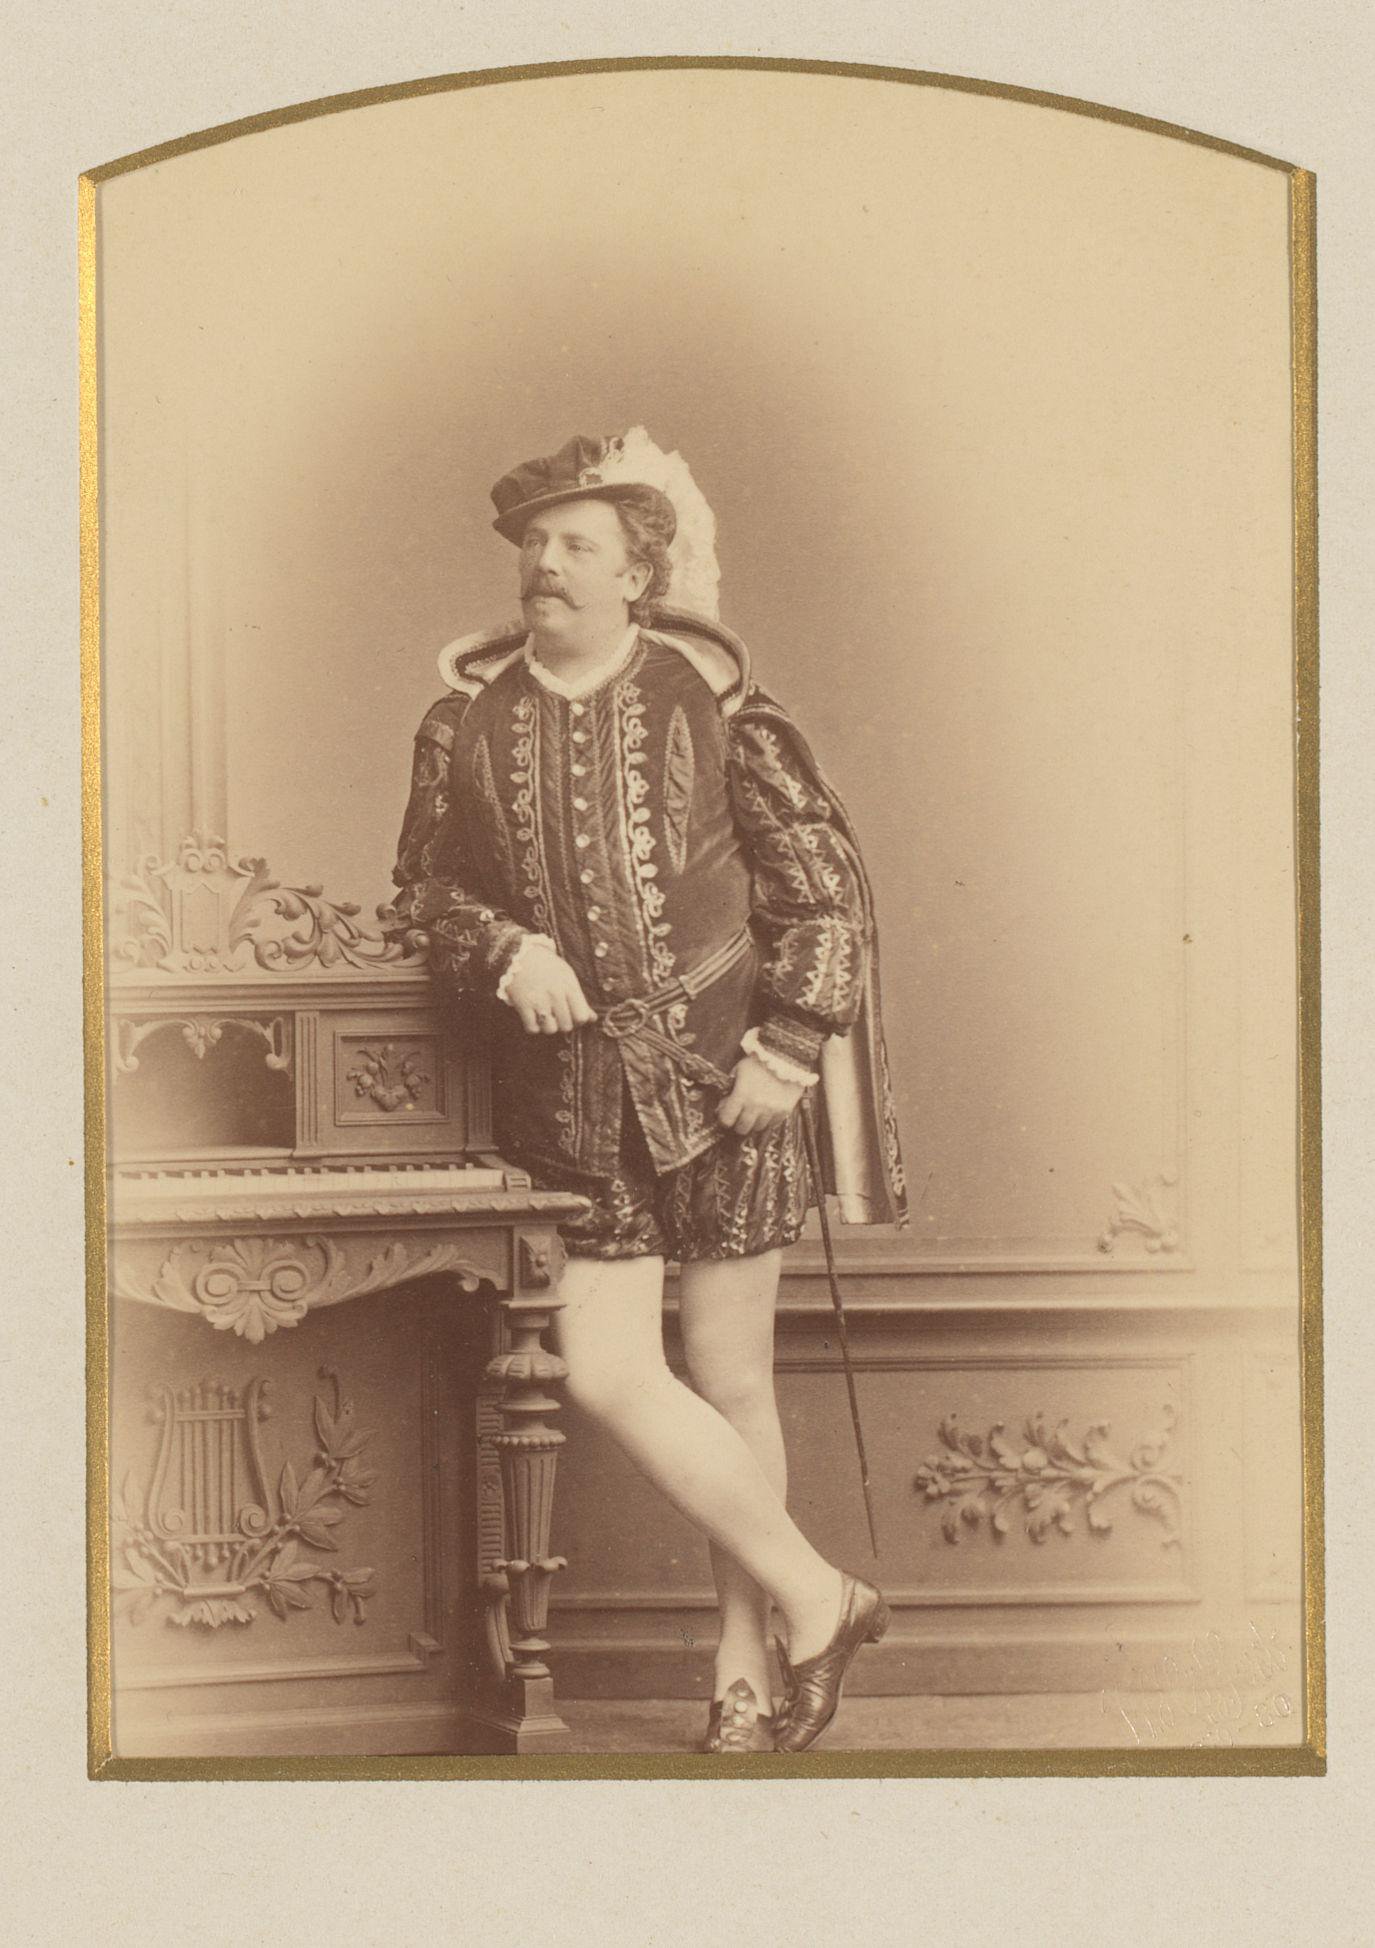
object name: cabinet photograph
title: Portret van Gustav Gunz, staand in maskeradekostuum bij bureau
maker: wilhelm höffert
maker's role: fotograaf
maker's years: 1832-1901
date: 1875-1881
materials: cardboard, photographic support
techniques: albumen print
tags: adult man, historical persons, portrait of opera-singer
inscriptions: annotation: ‘[...] G. Alsbach [...] zum errinering/ Rtterdam 24 4 81 Dr. G. Gunz’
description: Deze foto maakt deel uit van een omslag met 22 foto's.